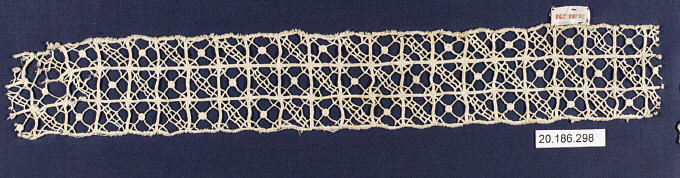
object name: insertion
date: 1501-1600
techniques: lace